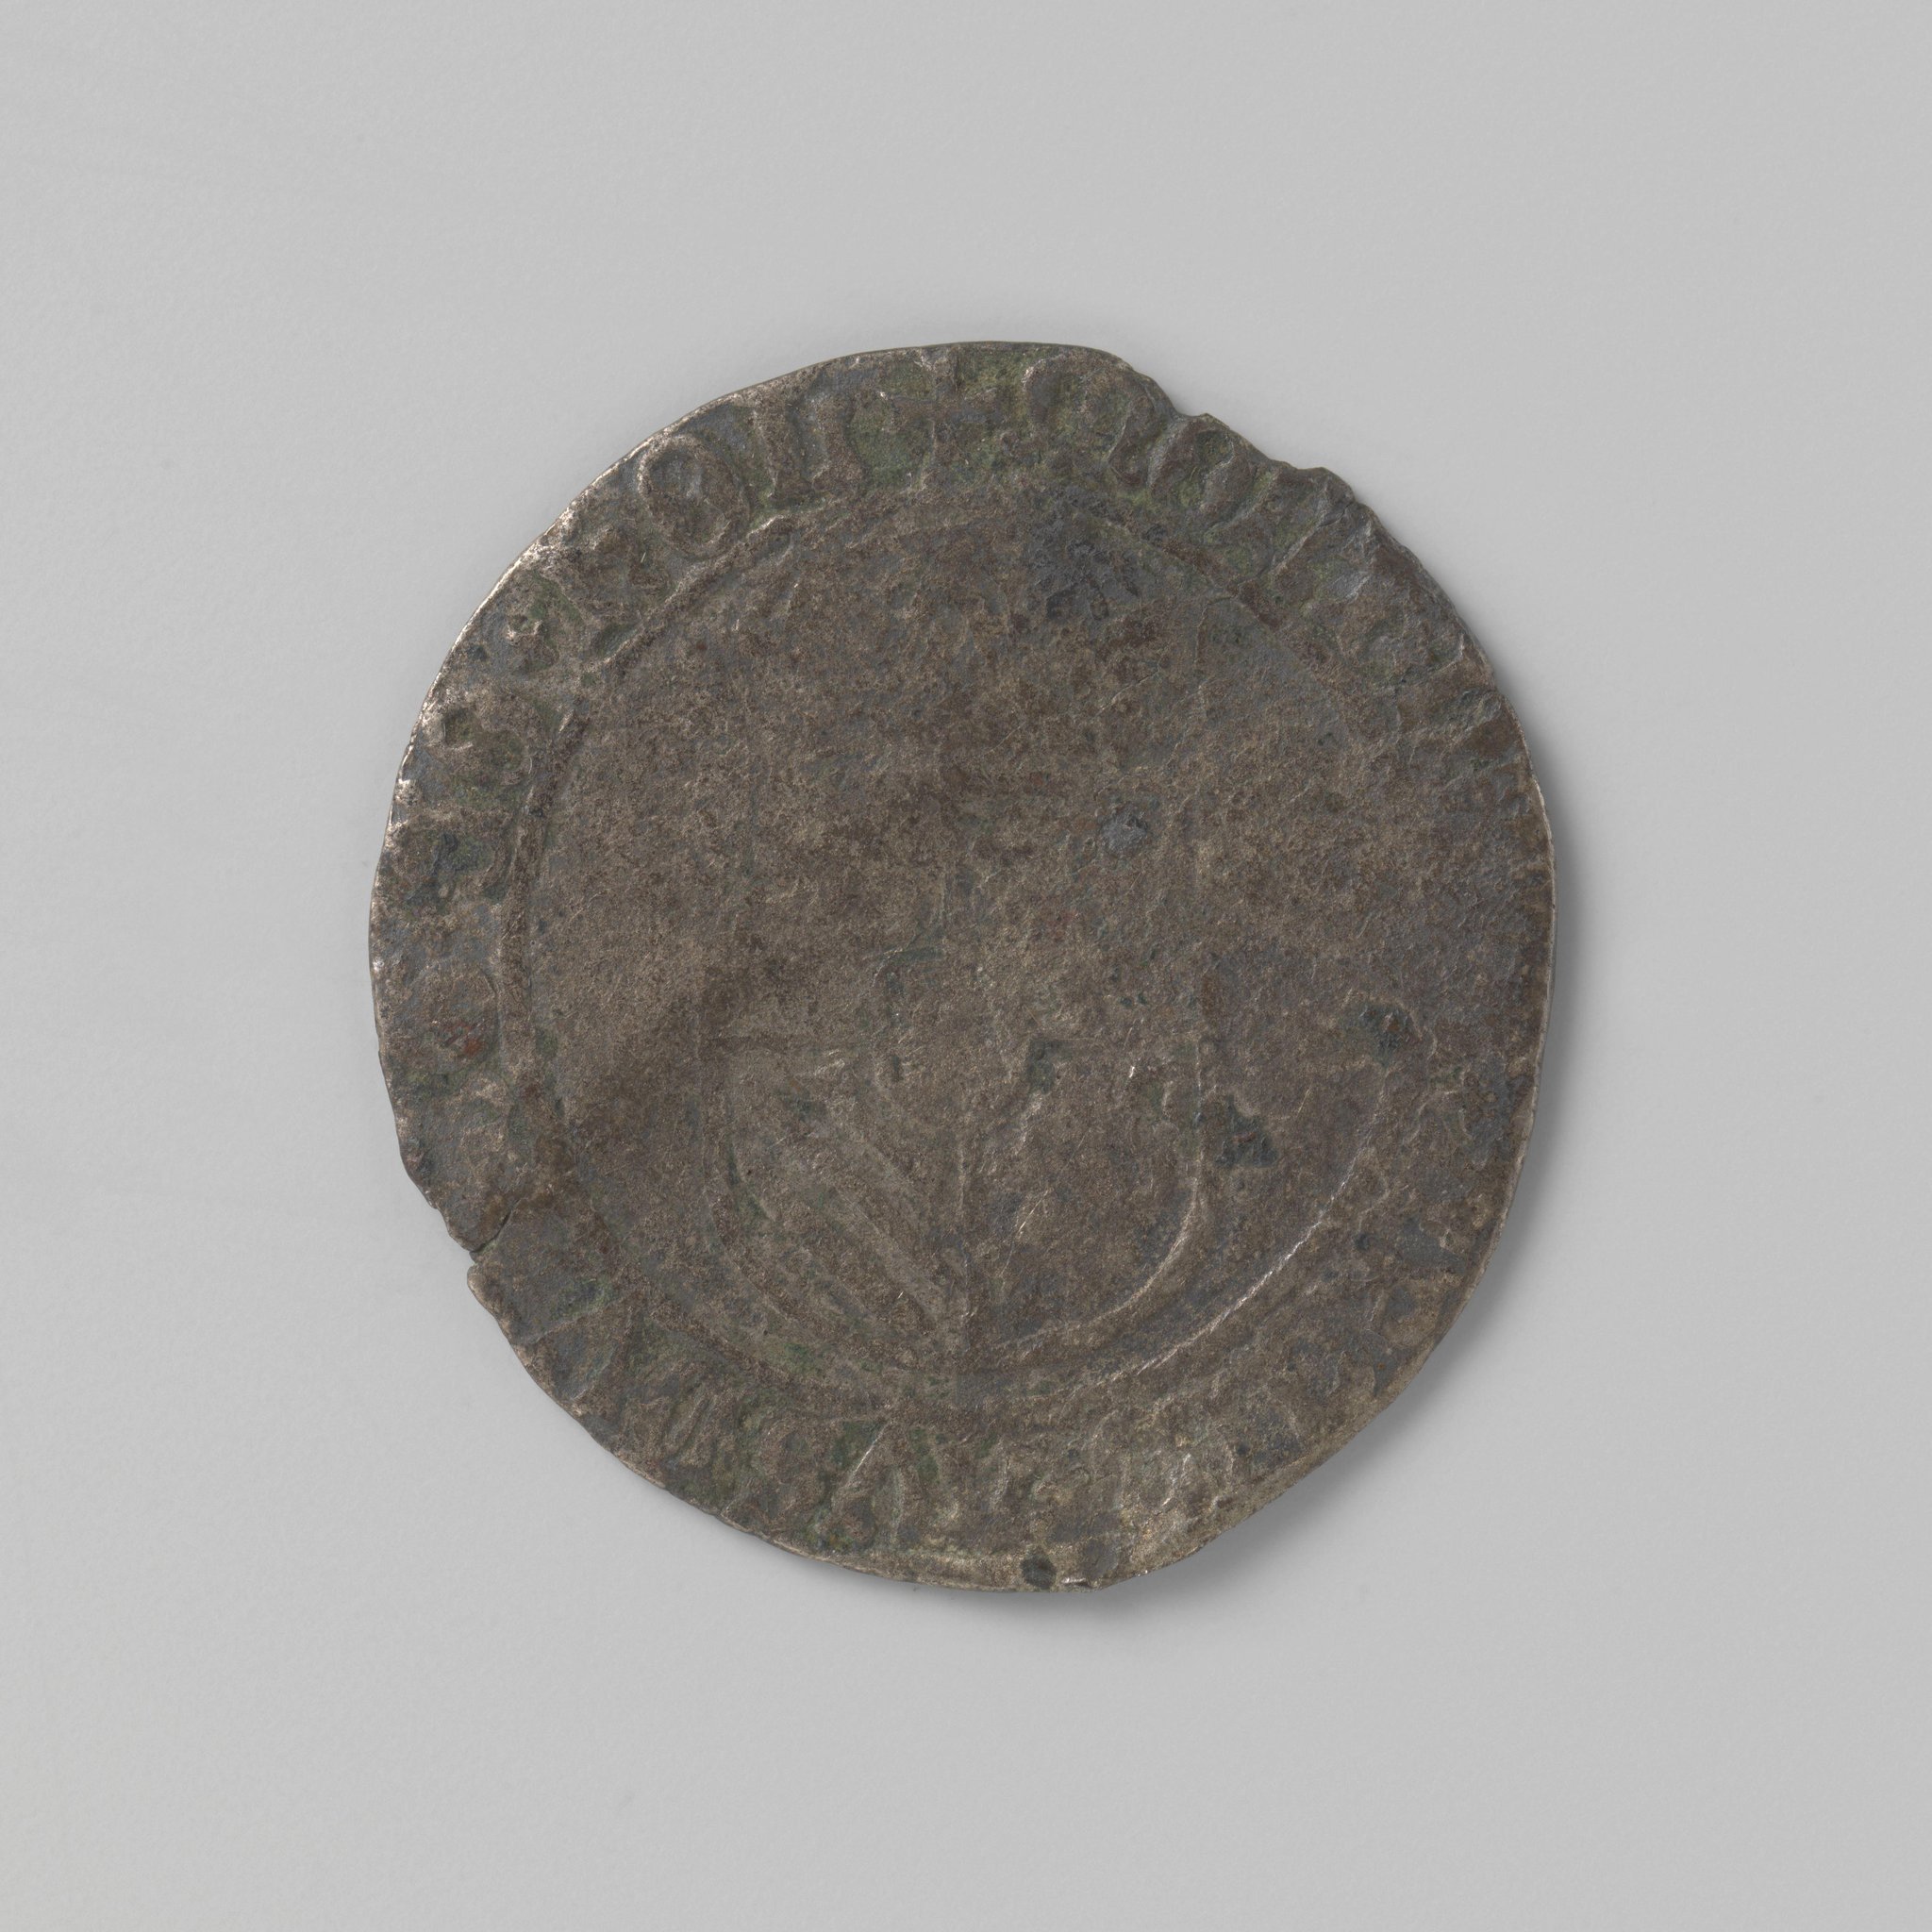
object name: coin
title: Hollandse stuiver, 1499 van Karel V, 1506-1555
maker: charles v (holy roman emperor and king of spain)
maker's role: keizer, koning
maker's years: 1500-1558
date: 1506-1520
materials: silver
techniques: striking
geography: dordrecht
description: Zilveren munt. Voorzijde: gekroond wapenschild van Oostenrijk-Bourgondië. Keerzijde: op een vierpas lang versierd kruis, in hart roos.